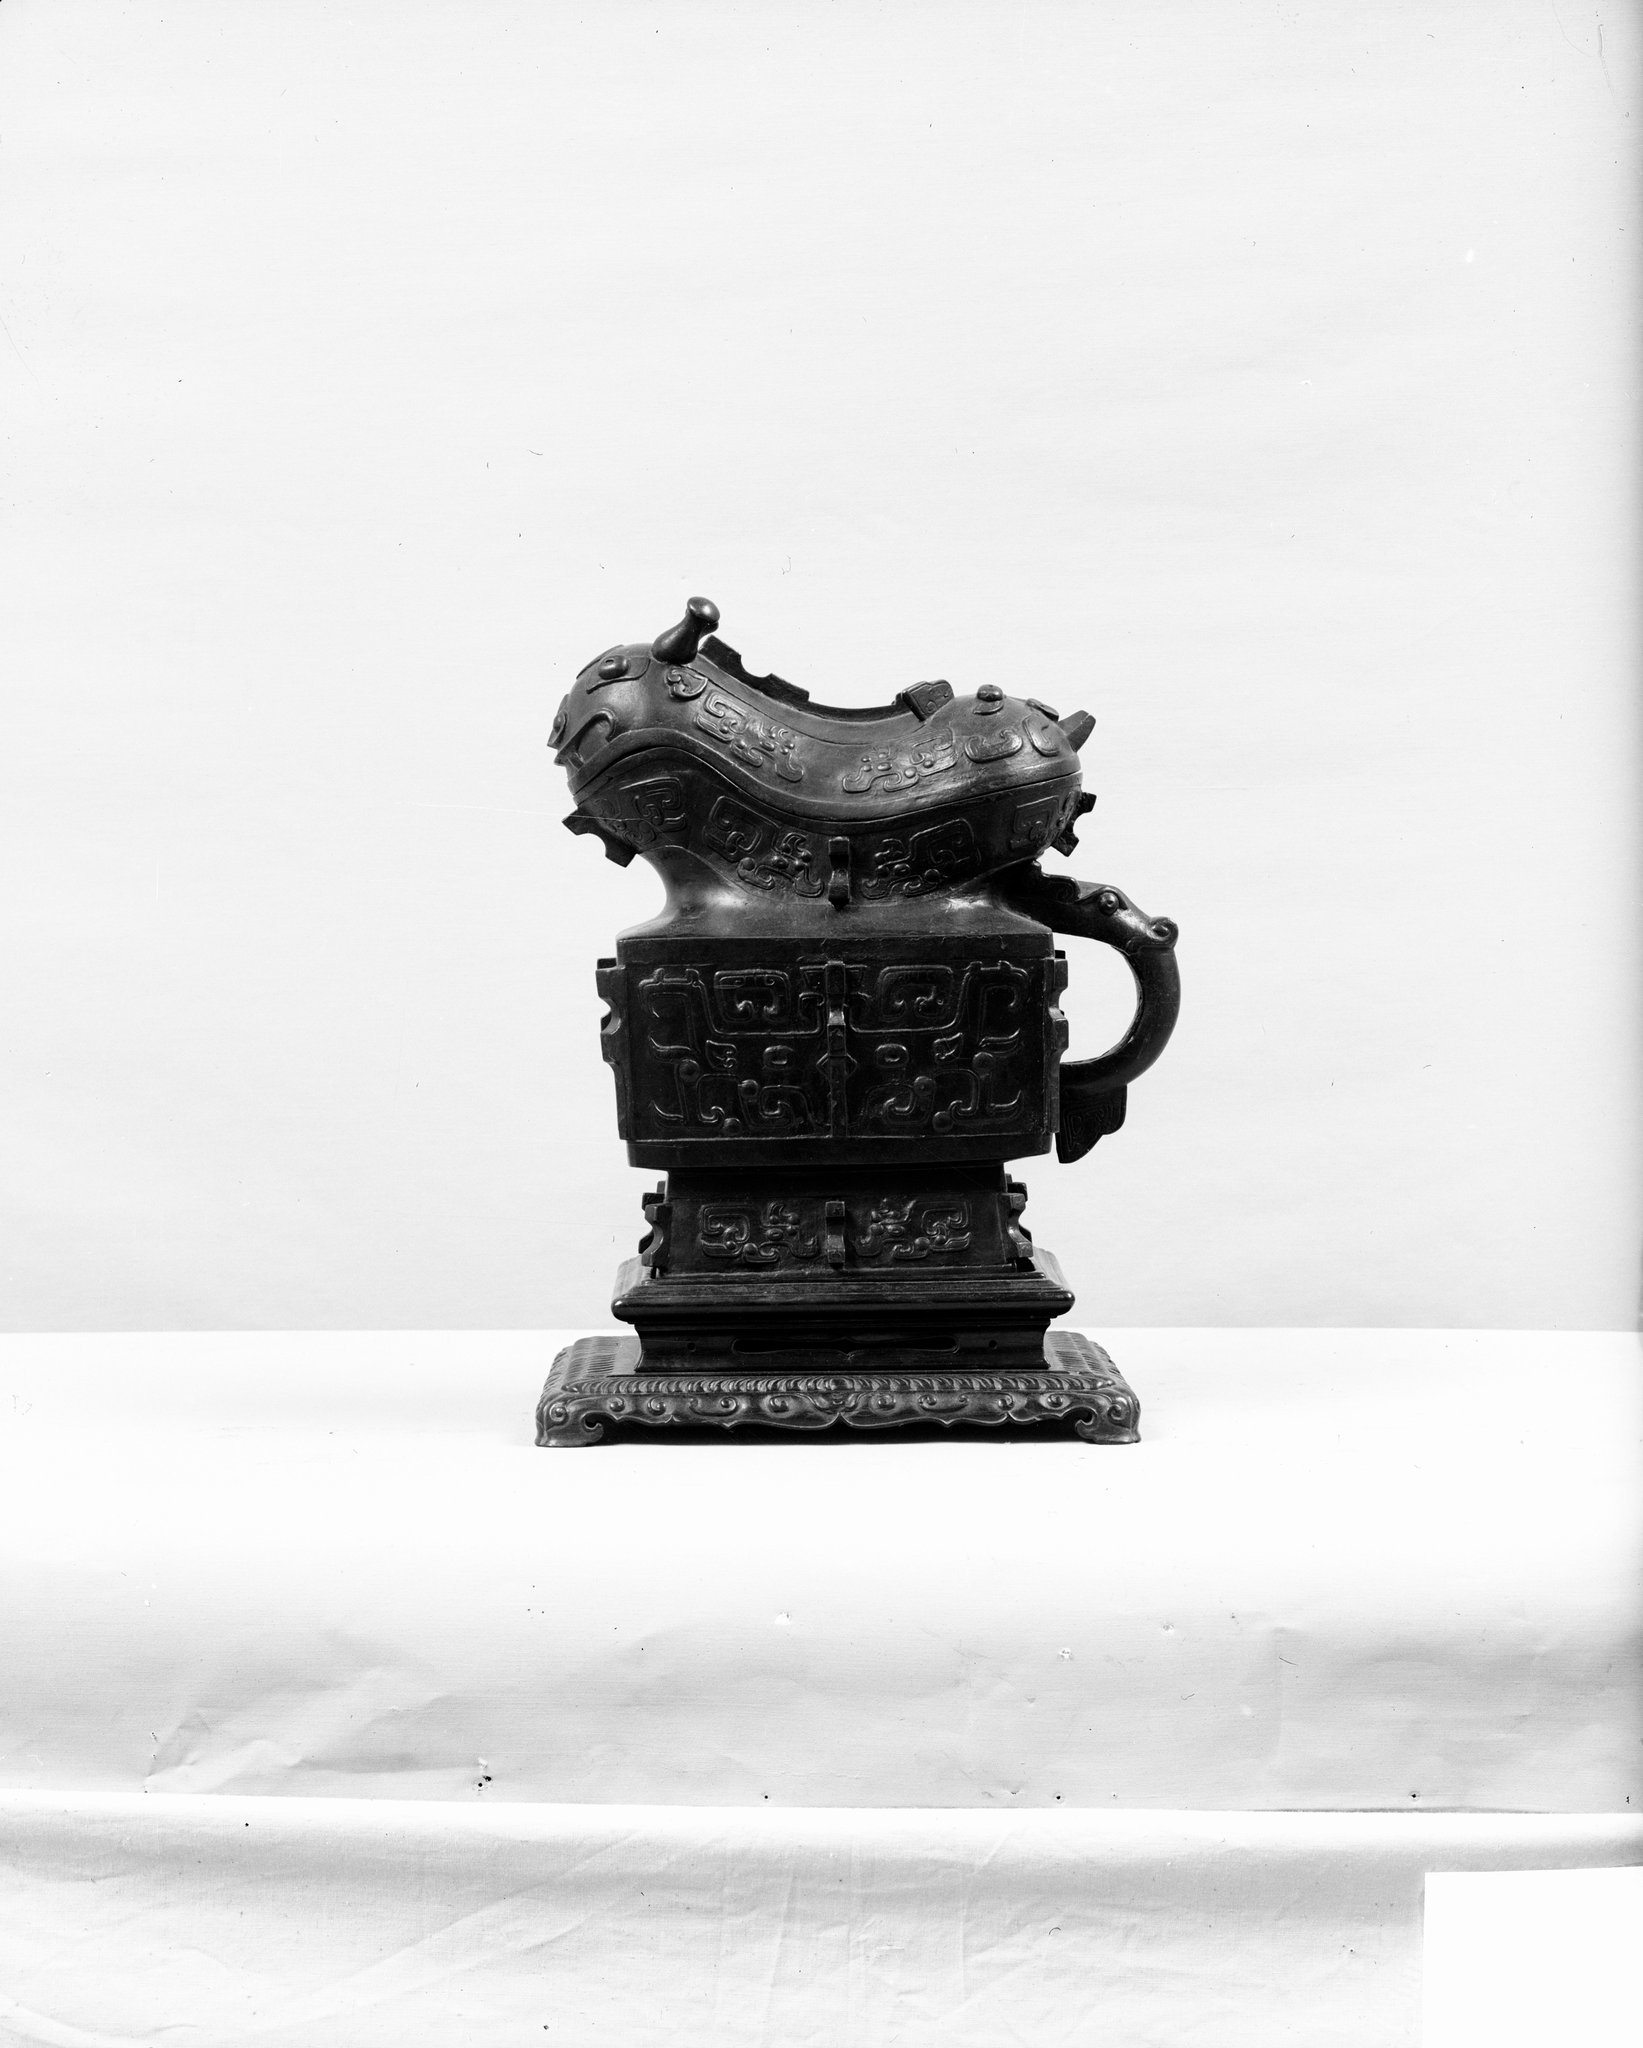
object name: vessel with cover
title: Vessel with cover (Zhou type)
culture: chinese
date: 1368-1644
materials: bronze